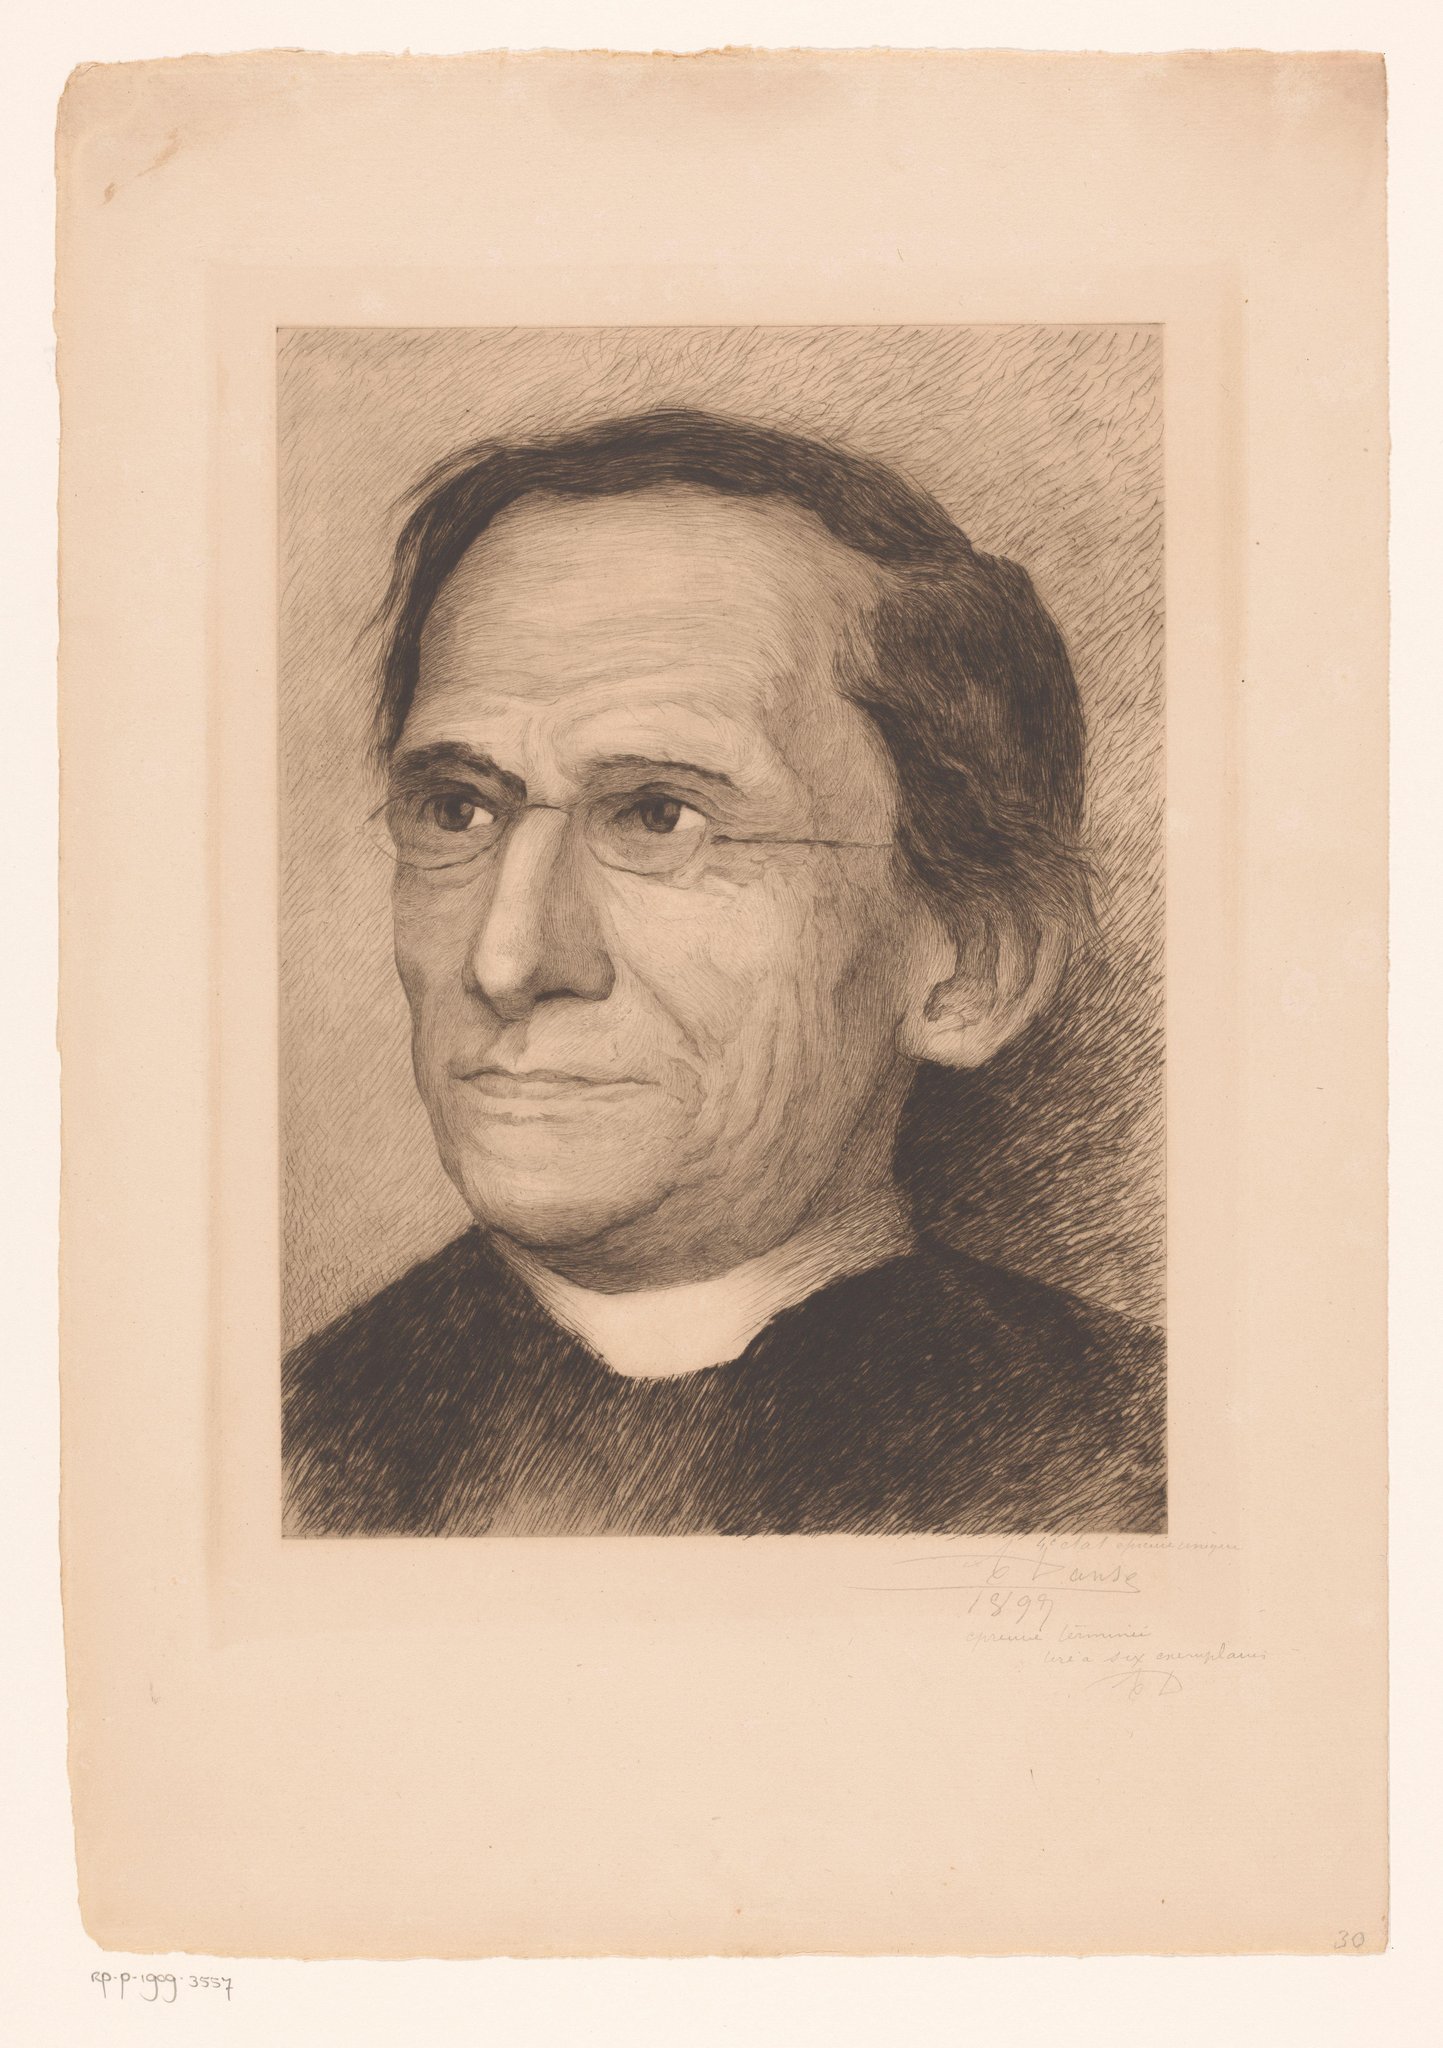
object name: print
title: Portret van Charles de Harlez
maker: auguste danse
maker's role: print maker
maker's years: 1829-1929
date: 1897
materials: paper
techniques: drypoint, etching, intaglio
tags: louvain, historical person (...) - historical person (...) portrayed alone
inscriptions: collector's mark: Lugt 2228, annotation: ‘4e etat epreuve unique; epreuve terminée tiré a six exemplaires’